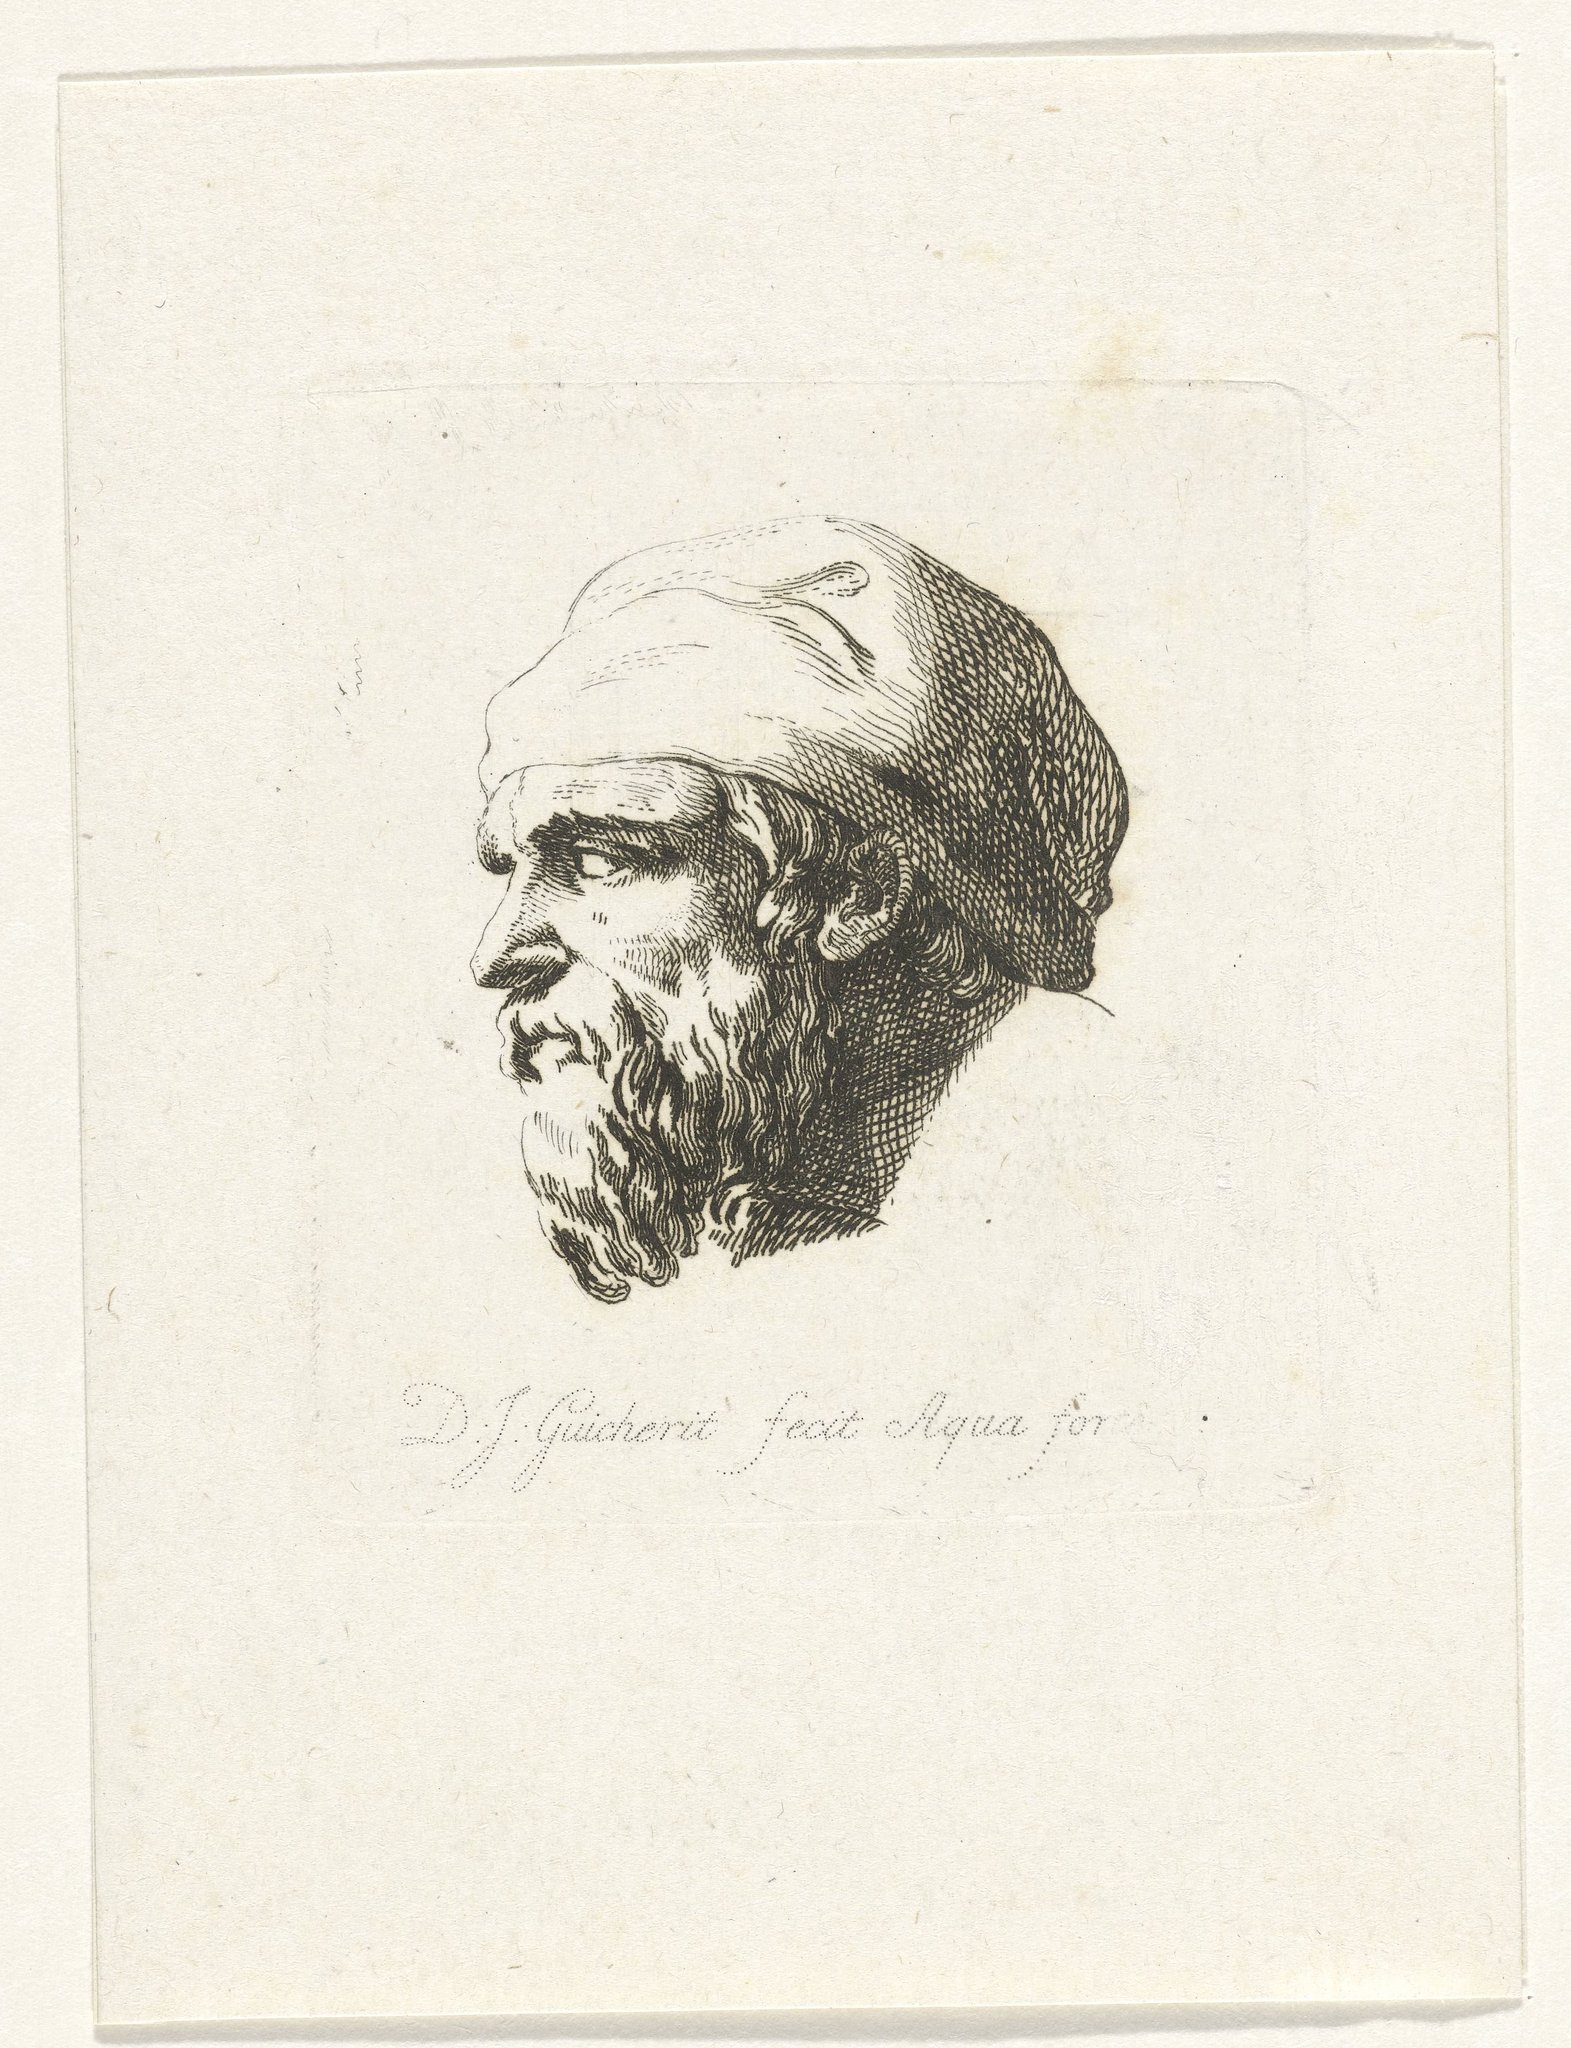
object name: print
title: Hoofd van man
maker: daniël jean guicherit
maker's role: print maker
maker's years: 1763-1813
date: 1778-1813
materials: paper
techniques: etching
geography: northern netherlands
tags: head-gear: hat (+ men's clothes)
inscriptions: collector's mark: Lugt 2228, collector's mark: Lugt 2760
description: Mannenkop in profiel, met baard en muts waaruit enkele haren te voorschijn komen die het oor onbedekt laten. Onder de voorstelling de signatuur van de kunstenaar.